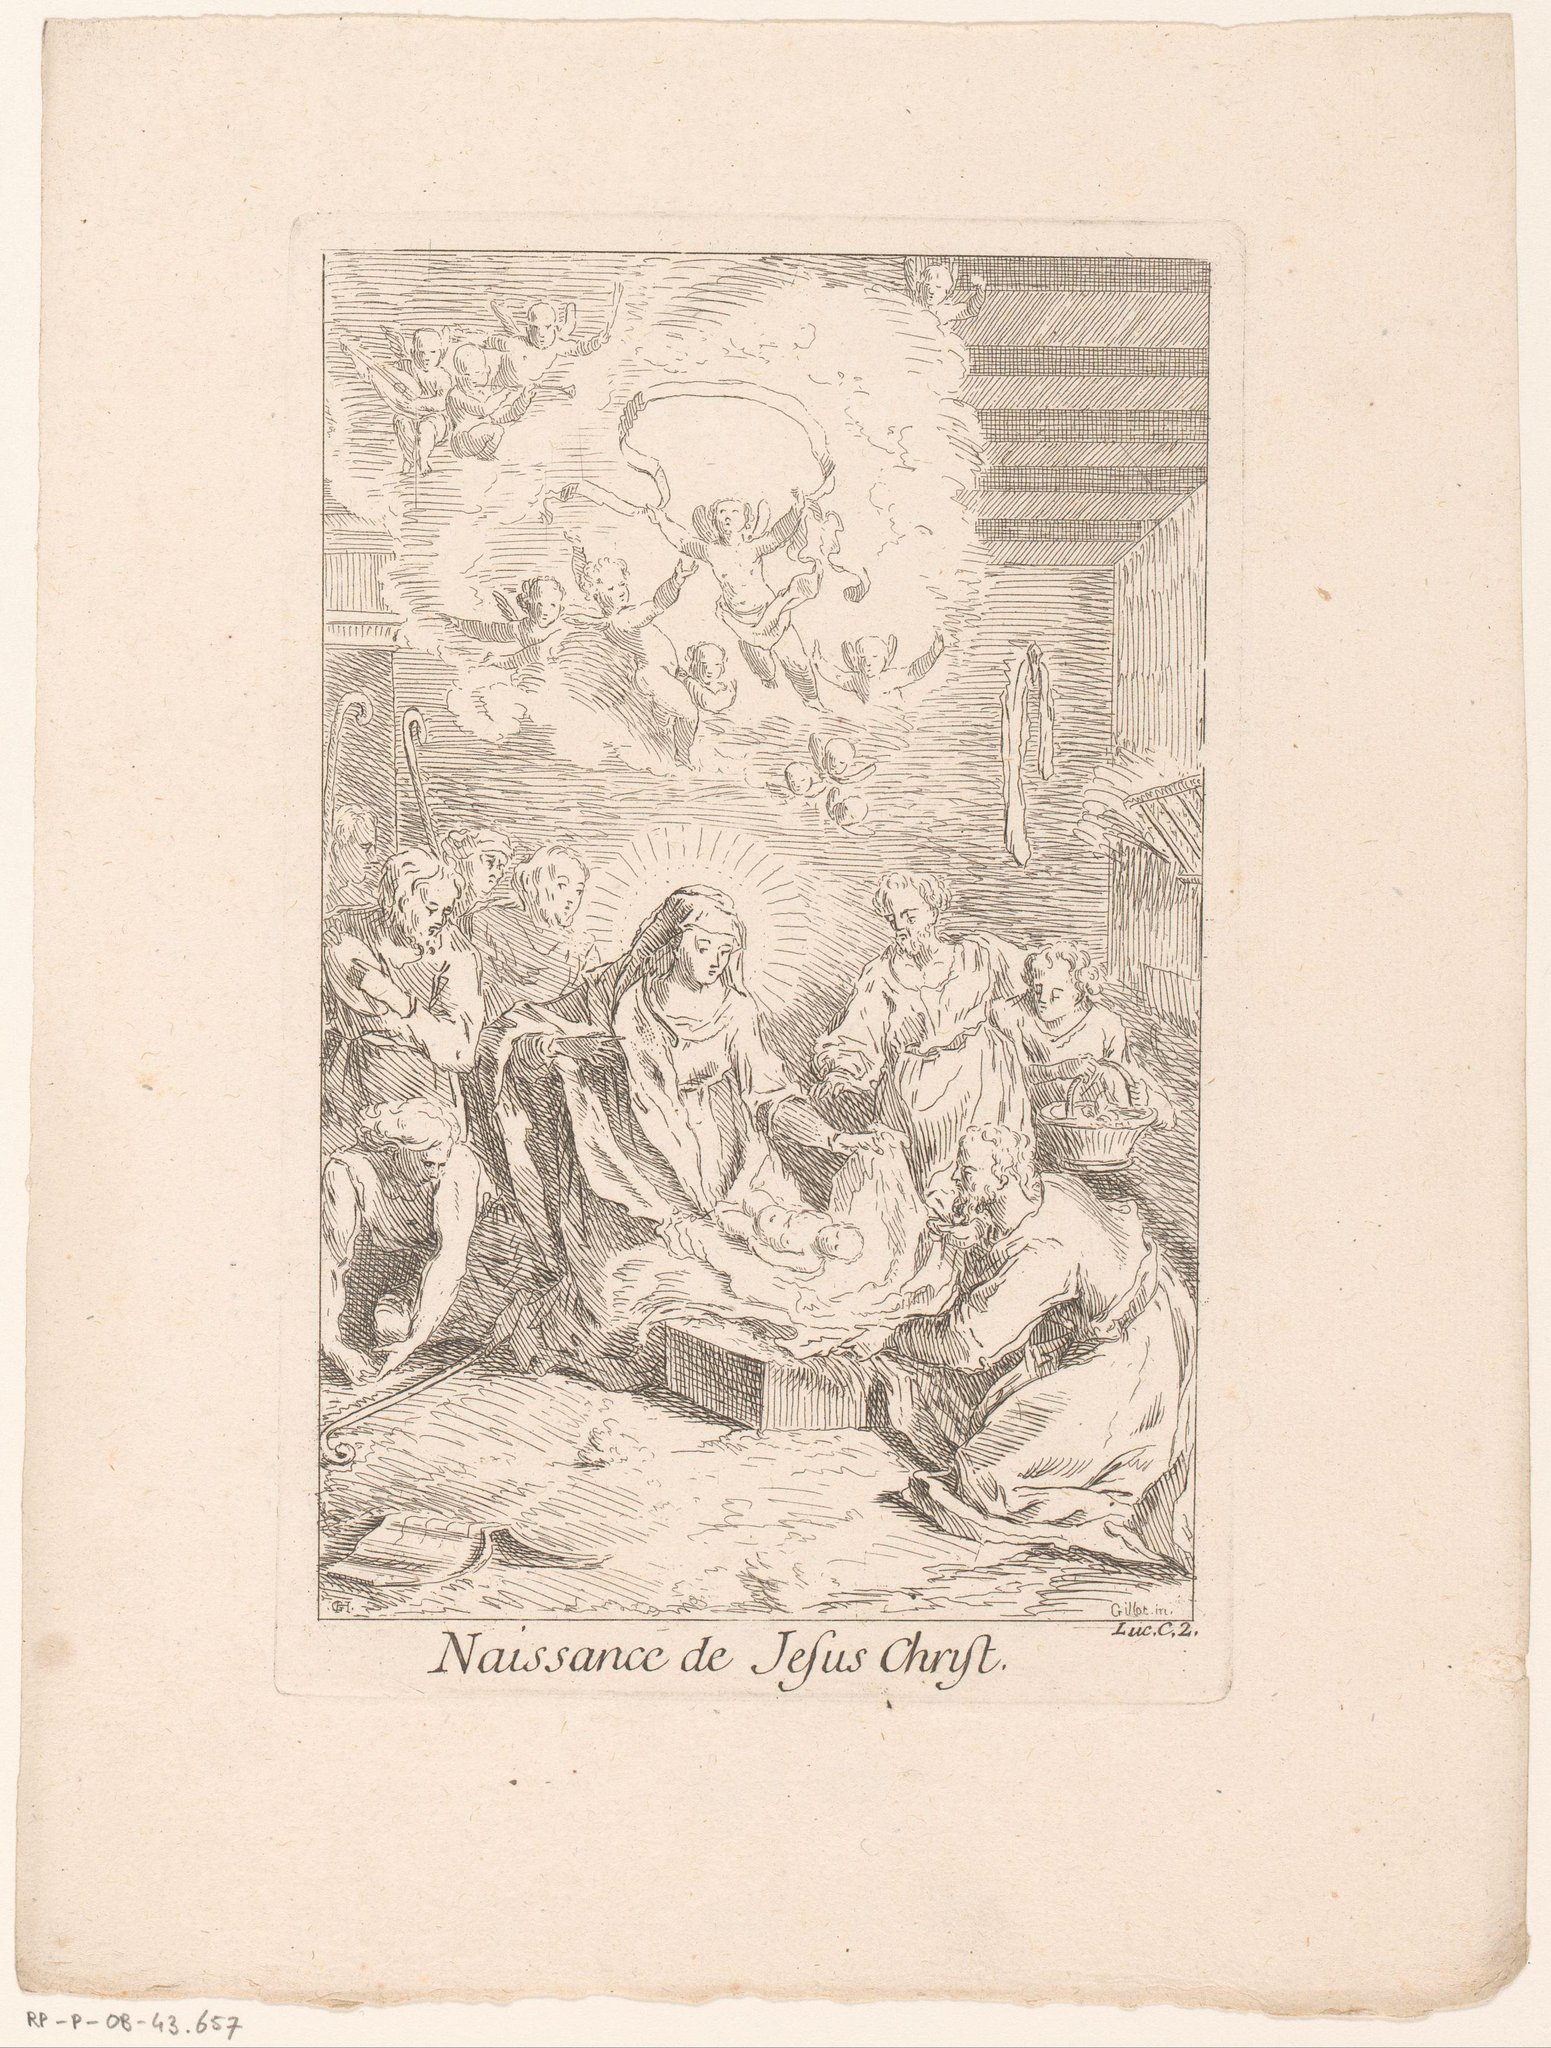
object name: print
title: Aanbidding door de herders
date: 1705-1732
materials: paper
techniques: etching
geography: france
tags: adoration of the christ-child by the shepherds; mary and joseph present (+ angel(s))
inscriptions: collector's mark: Lugt 2228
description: Maakt deel uit van een serie met zestig prenten met als thema het leven van Christus.